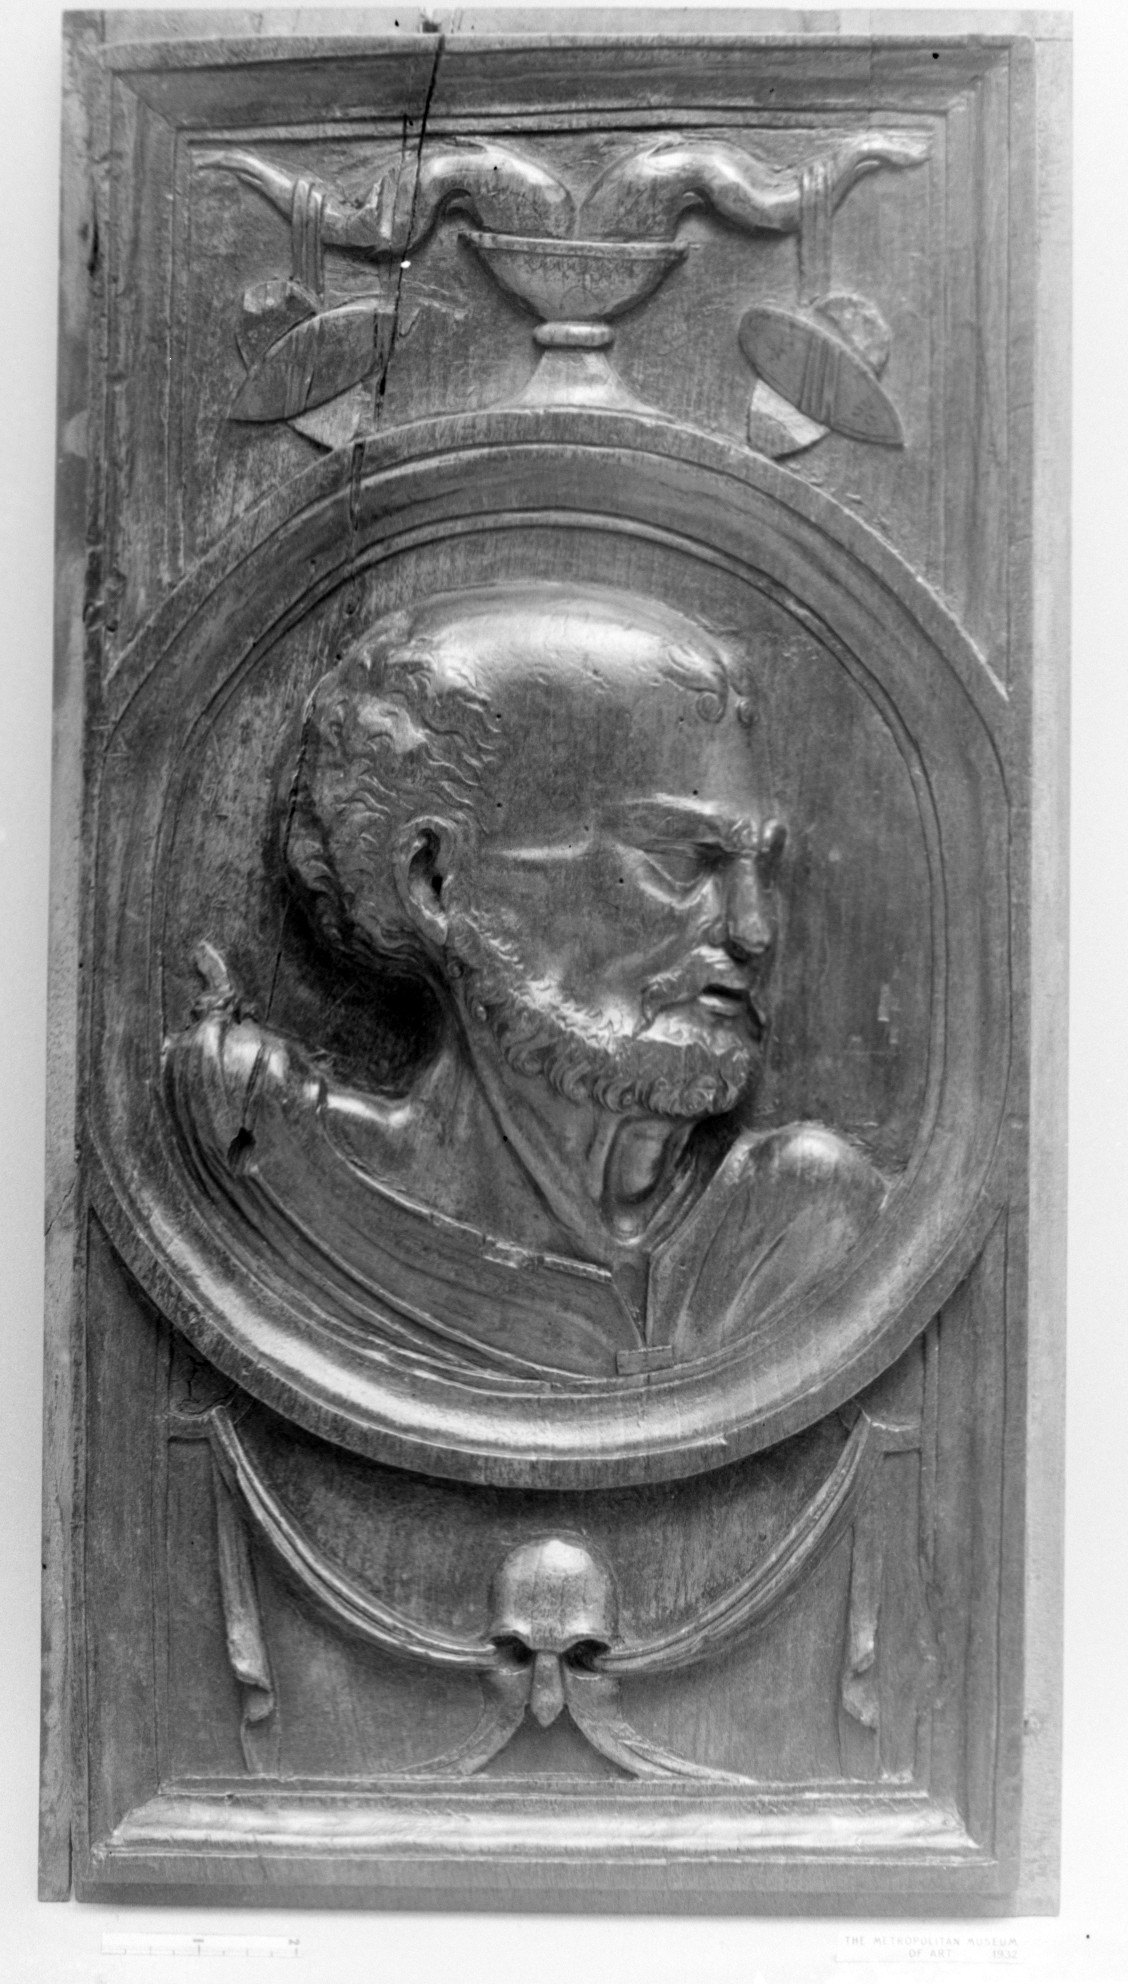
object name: panel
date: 1501-1600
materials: wood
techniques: carving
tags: profiles